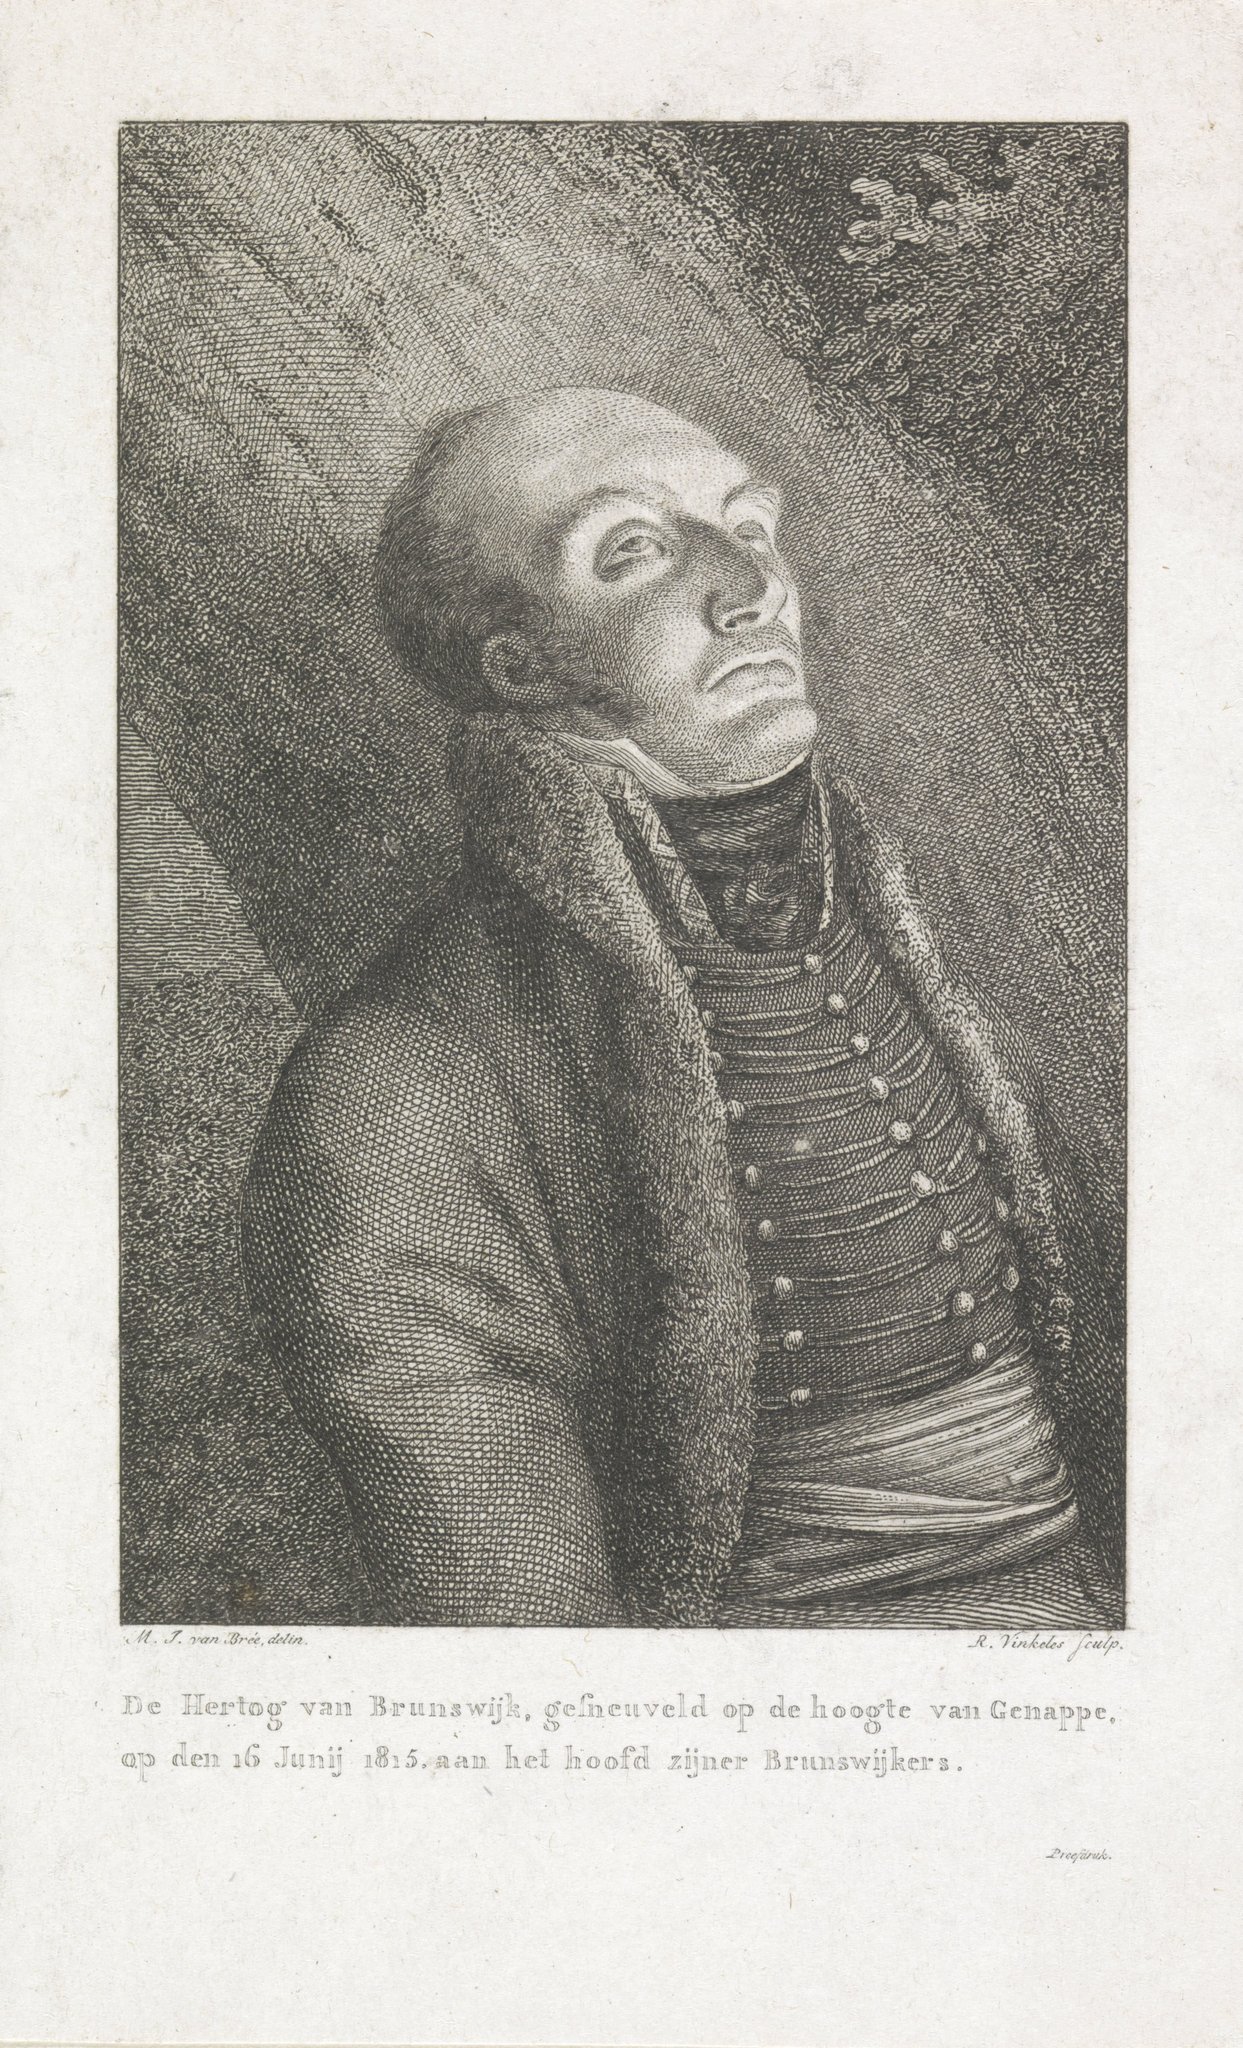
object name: print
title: De gesneuvelde Frederik Willem van Brunswijk, 1815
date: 1815-1816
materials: paper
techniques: engraving, etching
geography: netherlands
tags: violent death, being killed; being mishandled and maltreated; seeking death (+ death during war)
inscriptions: collector's mark: Lugt 2228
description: De gesneuvelde Frederik Willem, hertog van Brunswijk-Lüneburg-Oels, gedood tijdens de slag bij Quatre-Bras op 16 juni 1815. Onderdeel van een groep illustraties van gebeurtenissen rond en tijdens de veldslagen bij Quatre-Bras en Waterloo, 16-18 juni 1815.